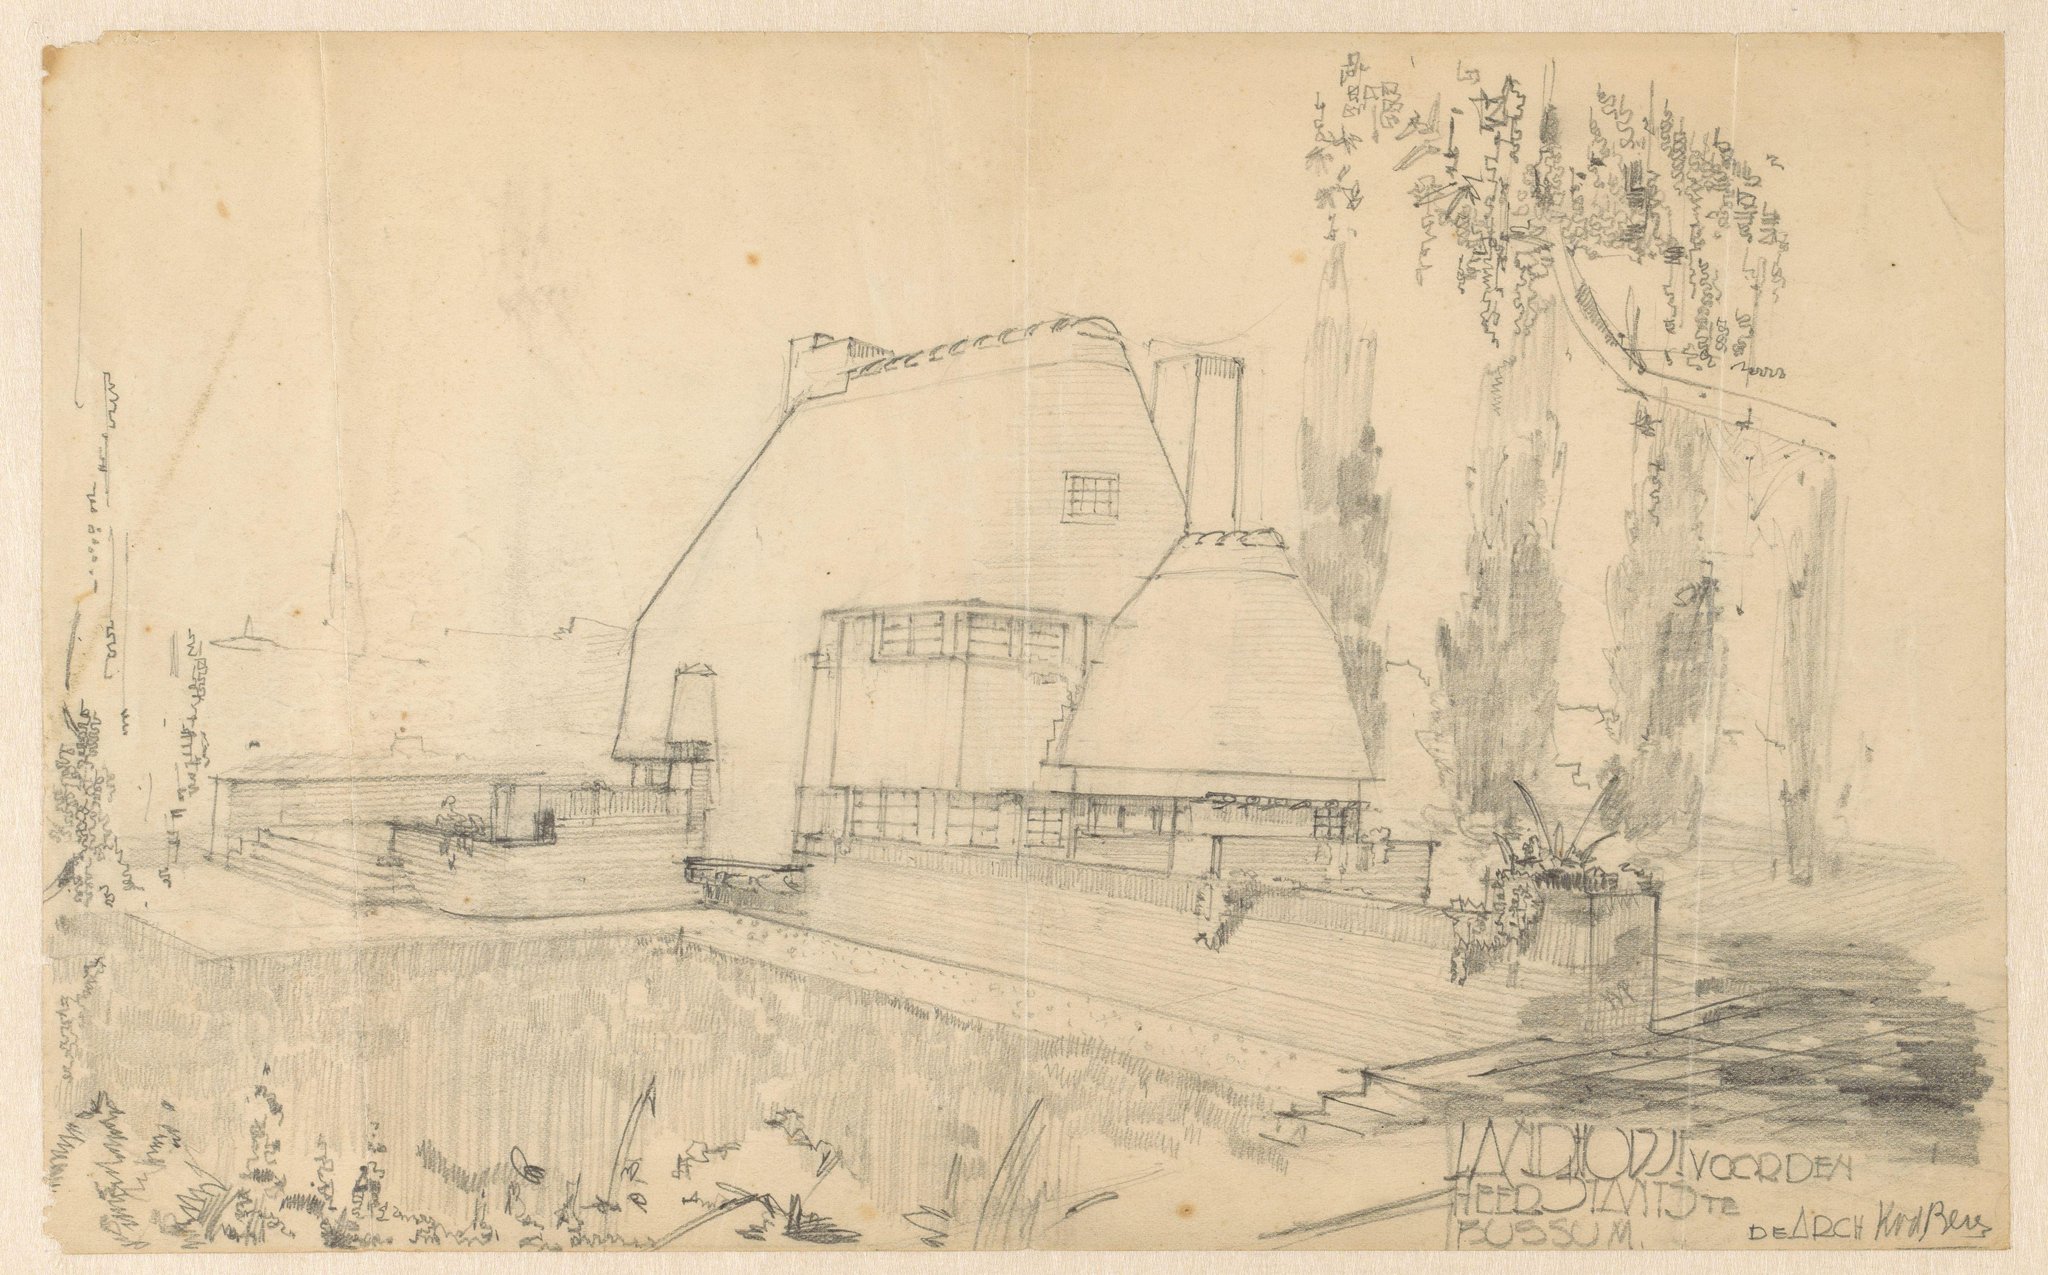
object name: drawing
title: Ontwerp voor een landhuis te Bussum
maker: k. v.d. berg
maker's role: draughtsman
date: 1929-1939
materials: paper, pencil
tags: rural housing, e.g. country-house, villa, cottage, exterior ~ architectural design or model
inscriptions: inscription: ‘LANDHUIS voor den/ heer Staats te/ BUSSUM/ de ARCH KvdBerg’